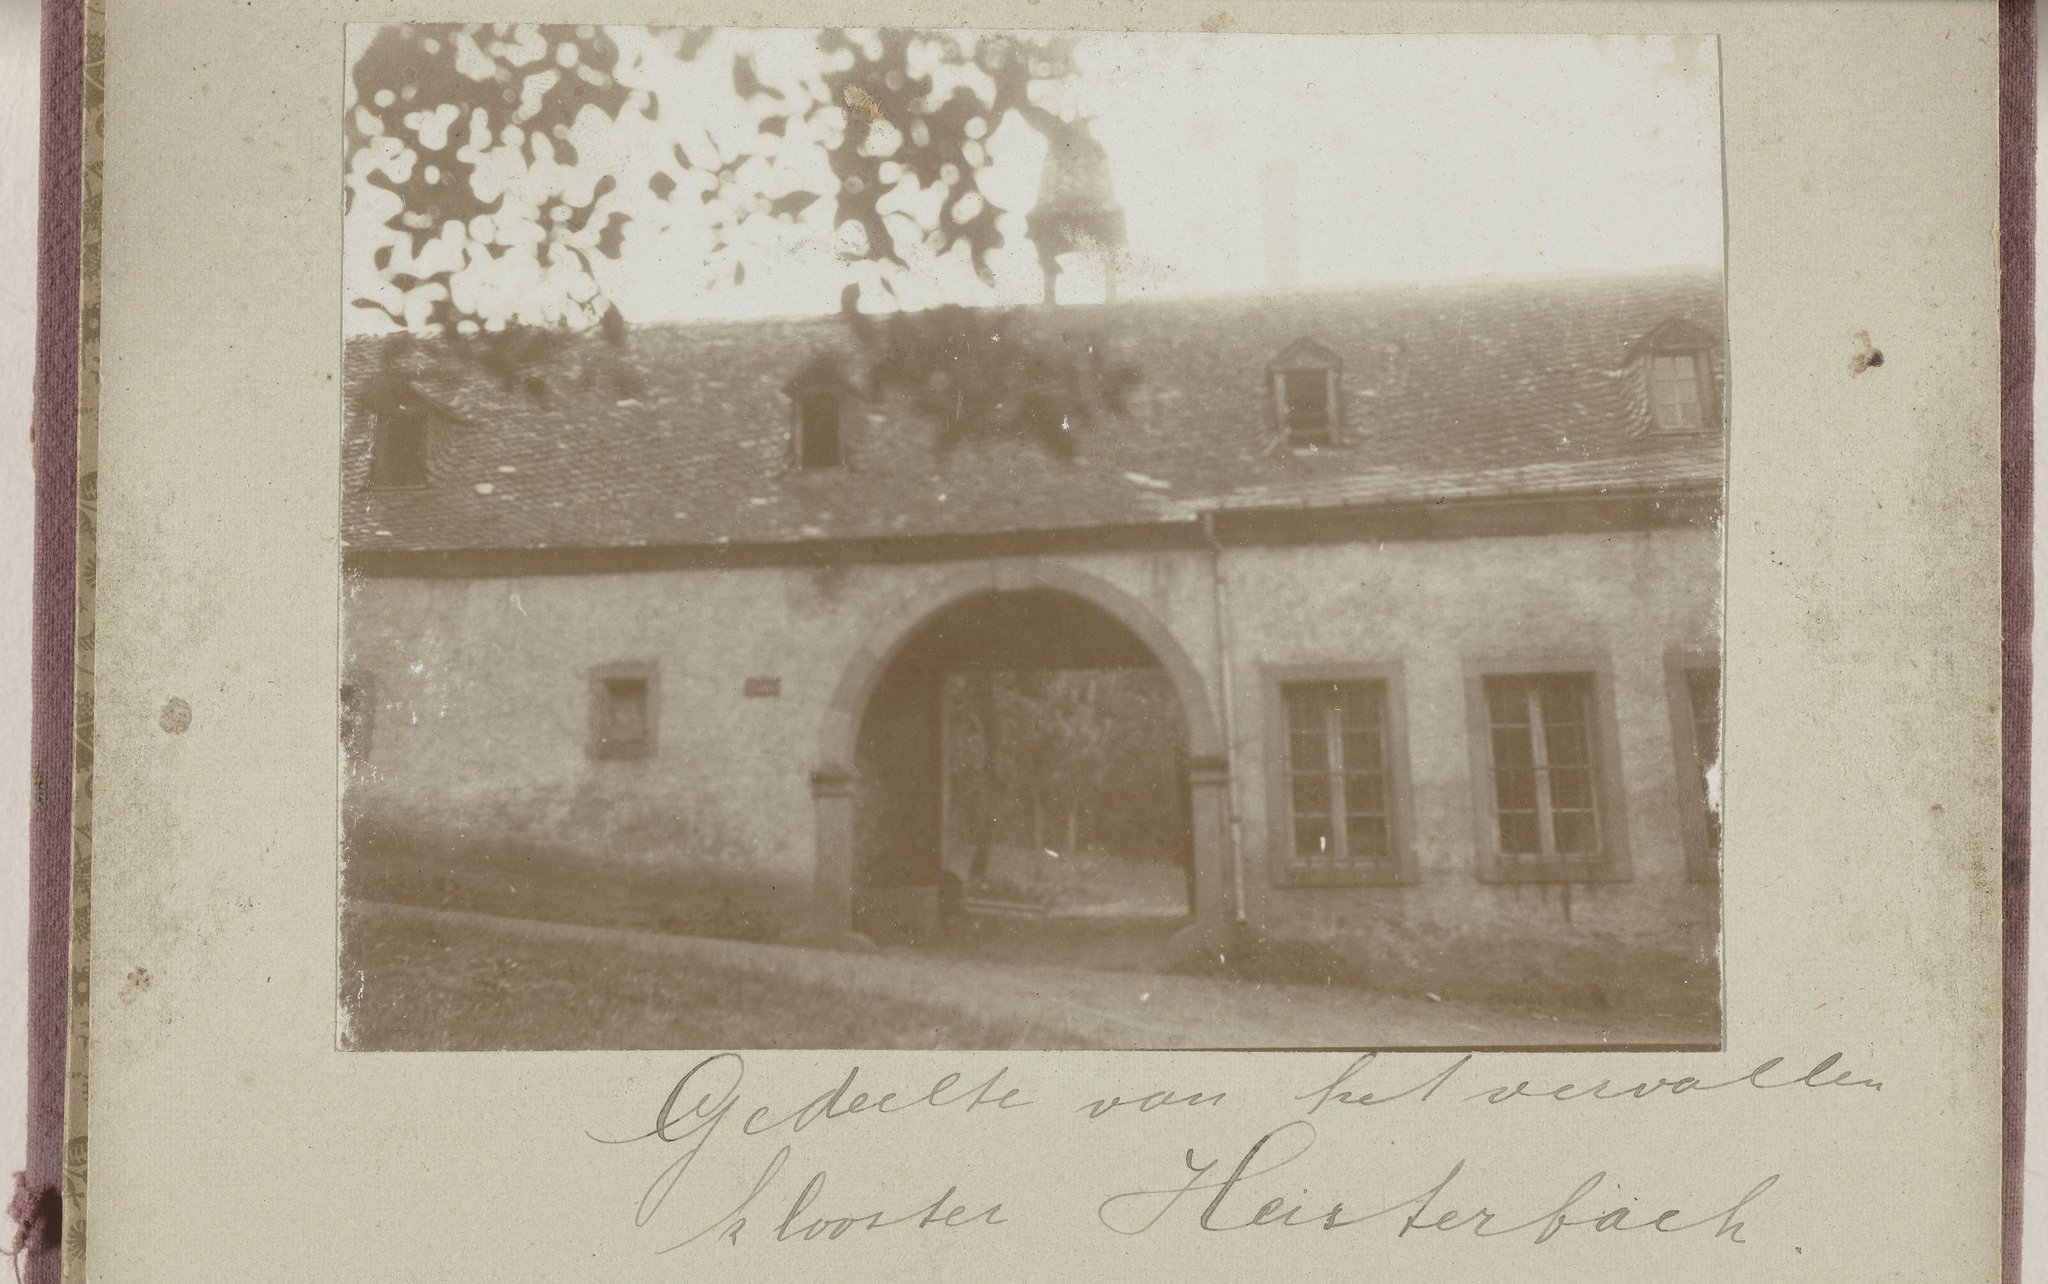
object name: album leaf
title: Gedeelte van het vervallen klooster Heisterbach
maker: david vermeulen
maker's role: fotograaf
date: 1895-1905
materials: paper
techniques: collodion silver print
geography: heisterbach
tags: abbey, monastery, convent ~ roman catholic church, gate, entrance